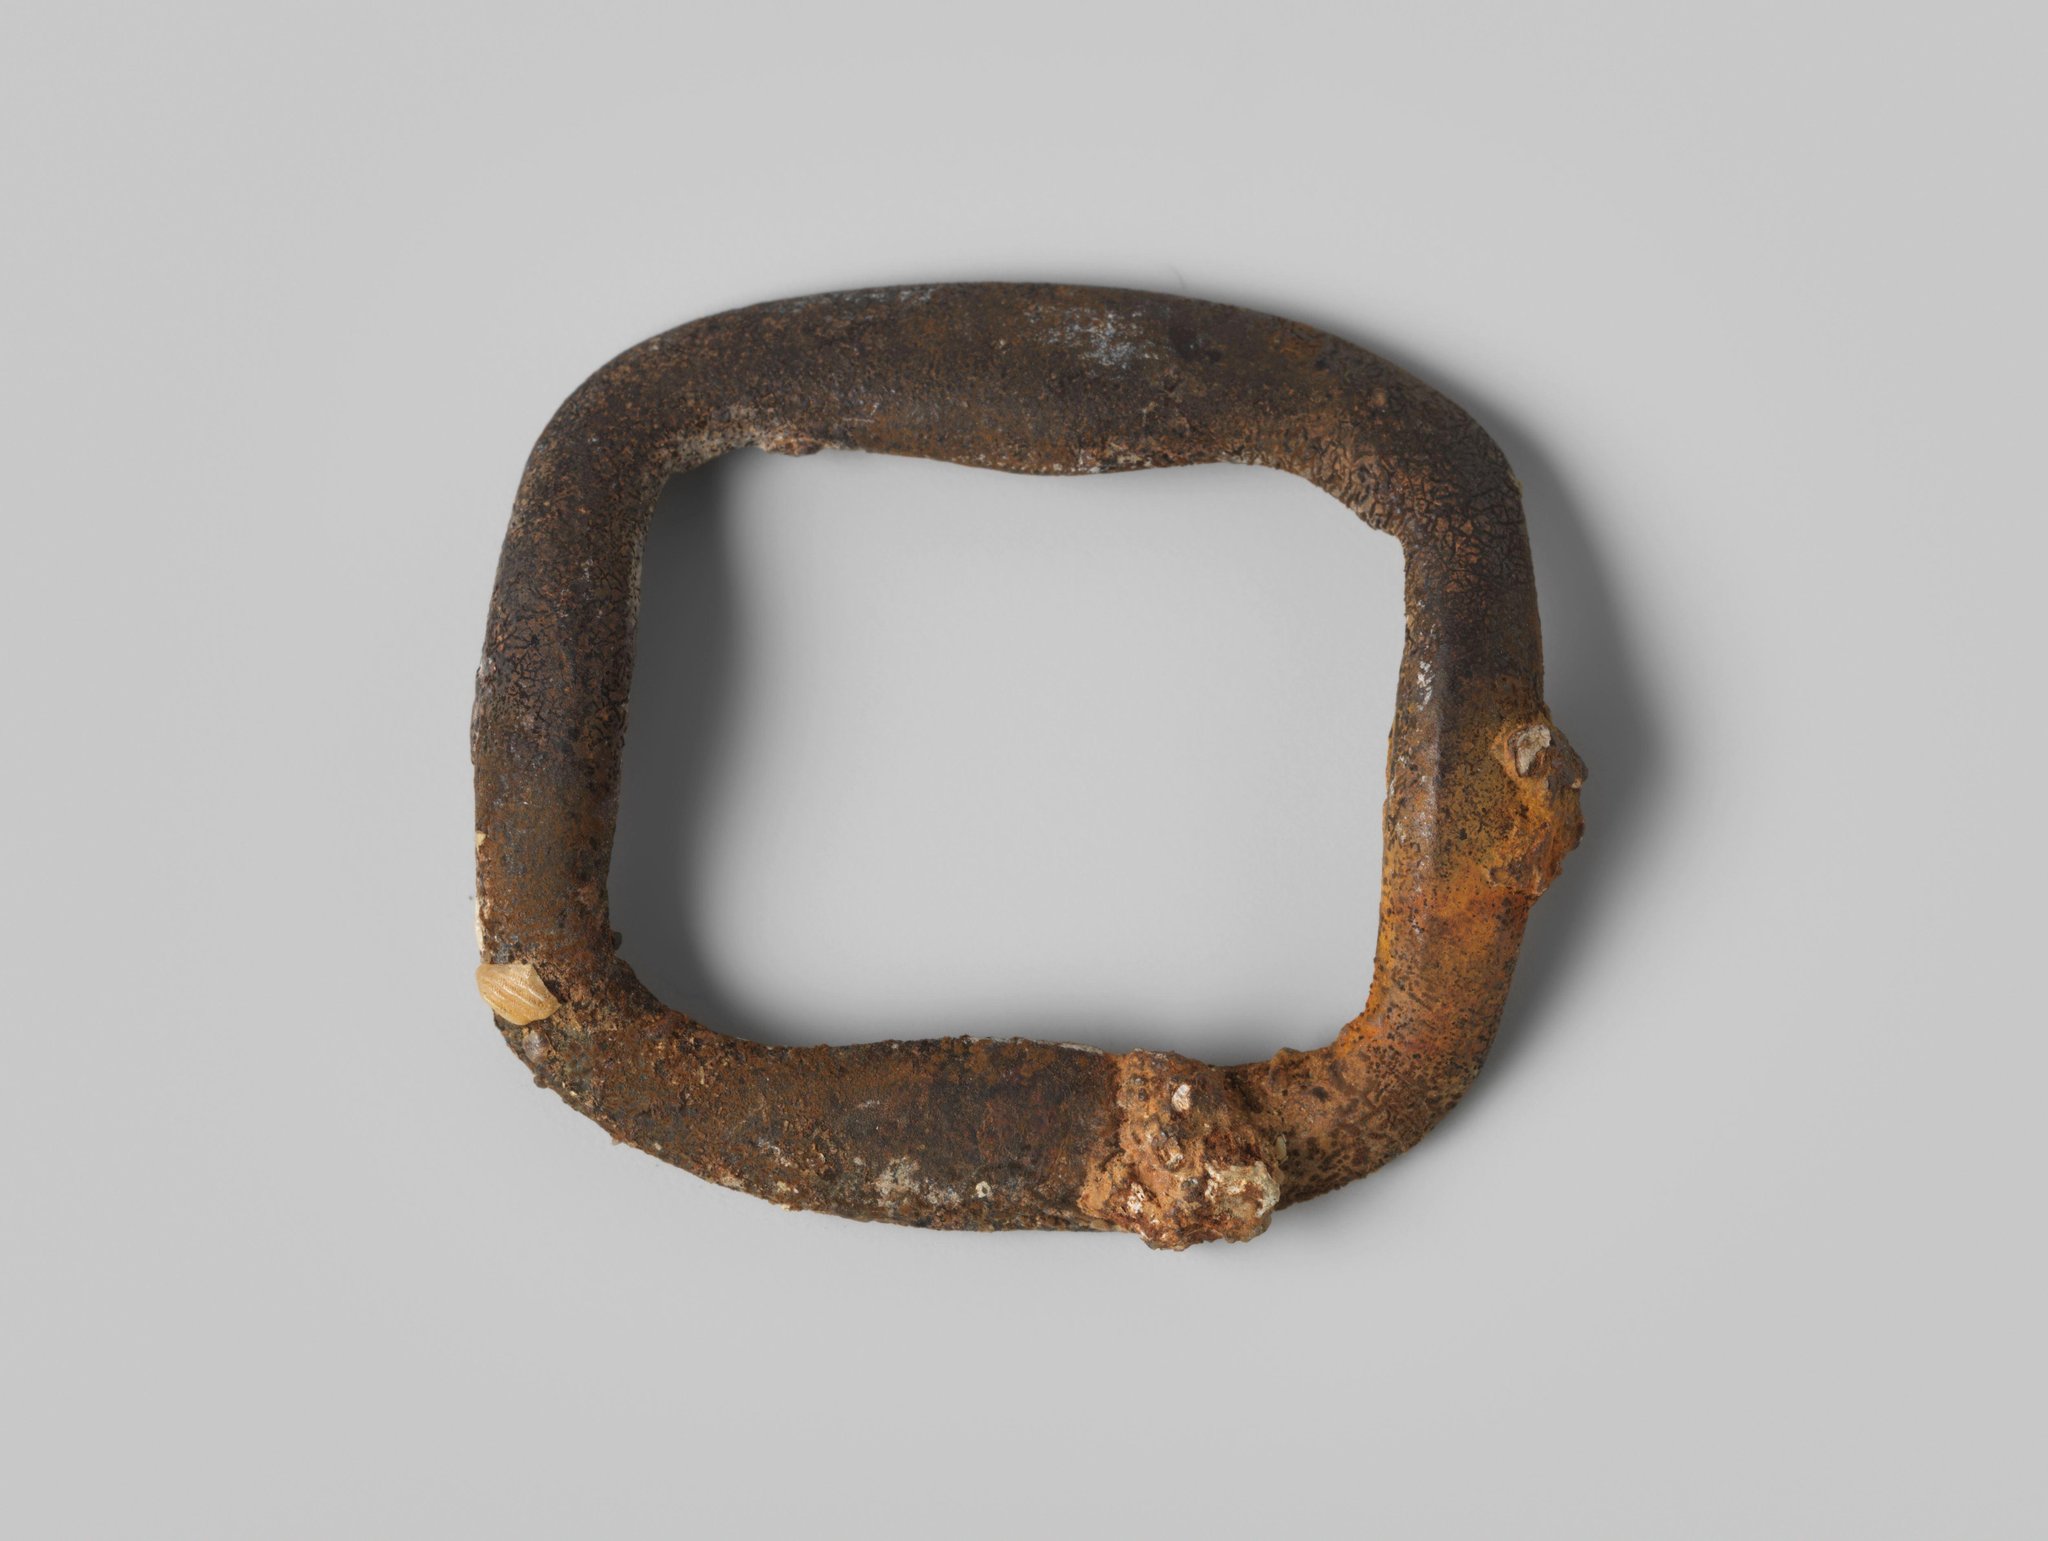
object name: knee buckle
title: Kniegesp uit het wrak van de Oost-Indiëvaarder Hollandia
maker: Anonymous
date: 1700-1743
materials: copper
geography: netherlands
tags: verenigde oostindische compagnie, hollandia (schip), annet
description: Buckle, chape buckle, knee buckle; ring, plain (spindle longitudinal).